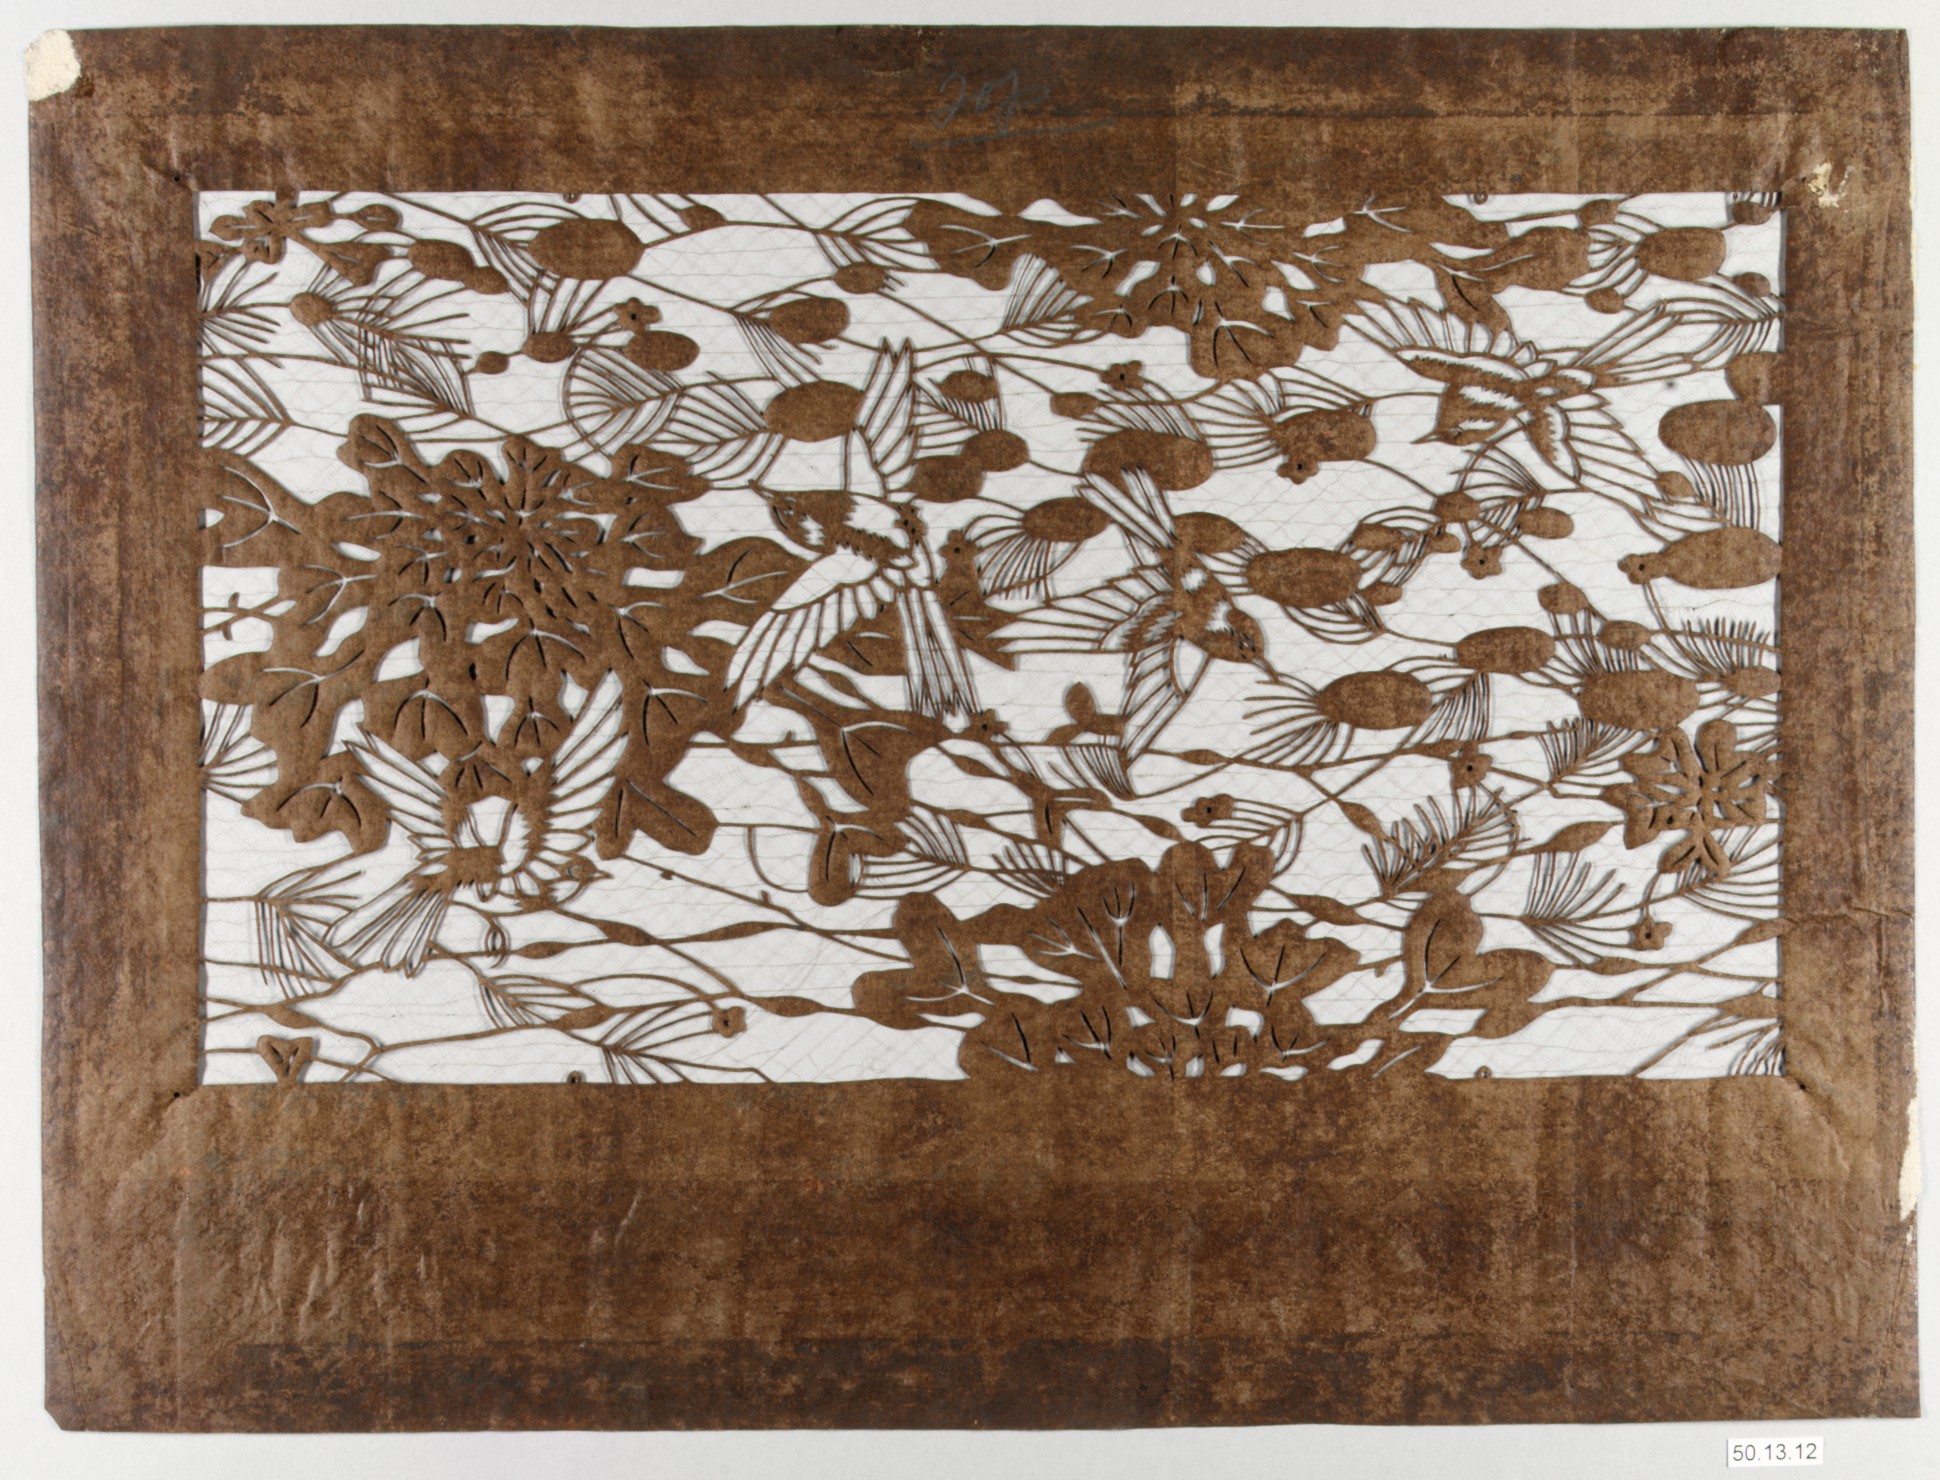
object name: stencil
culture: japanese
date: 1801-1900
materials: paper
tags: flowers